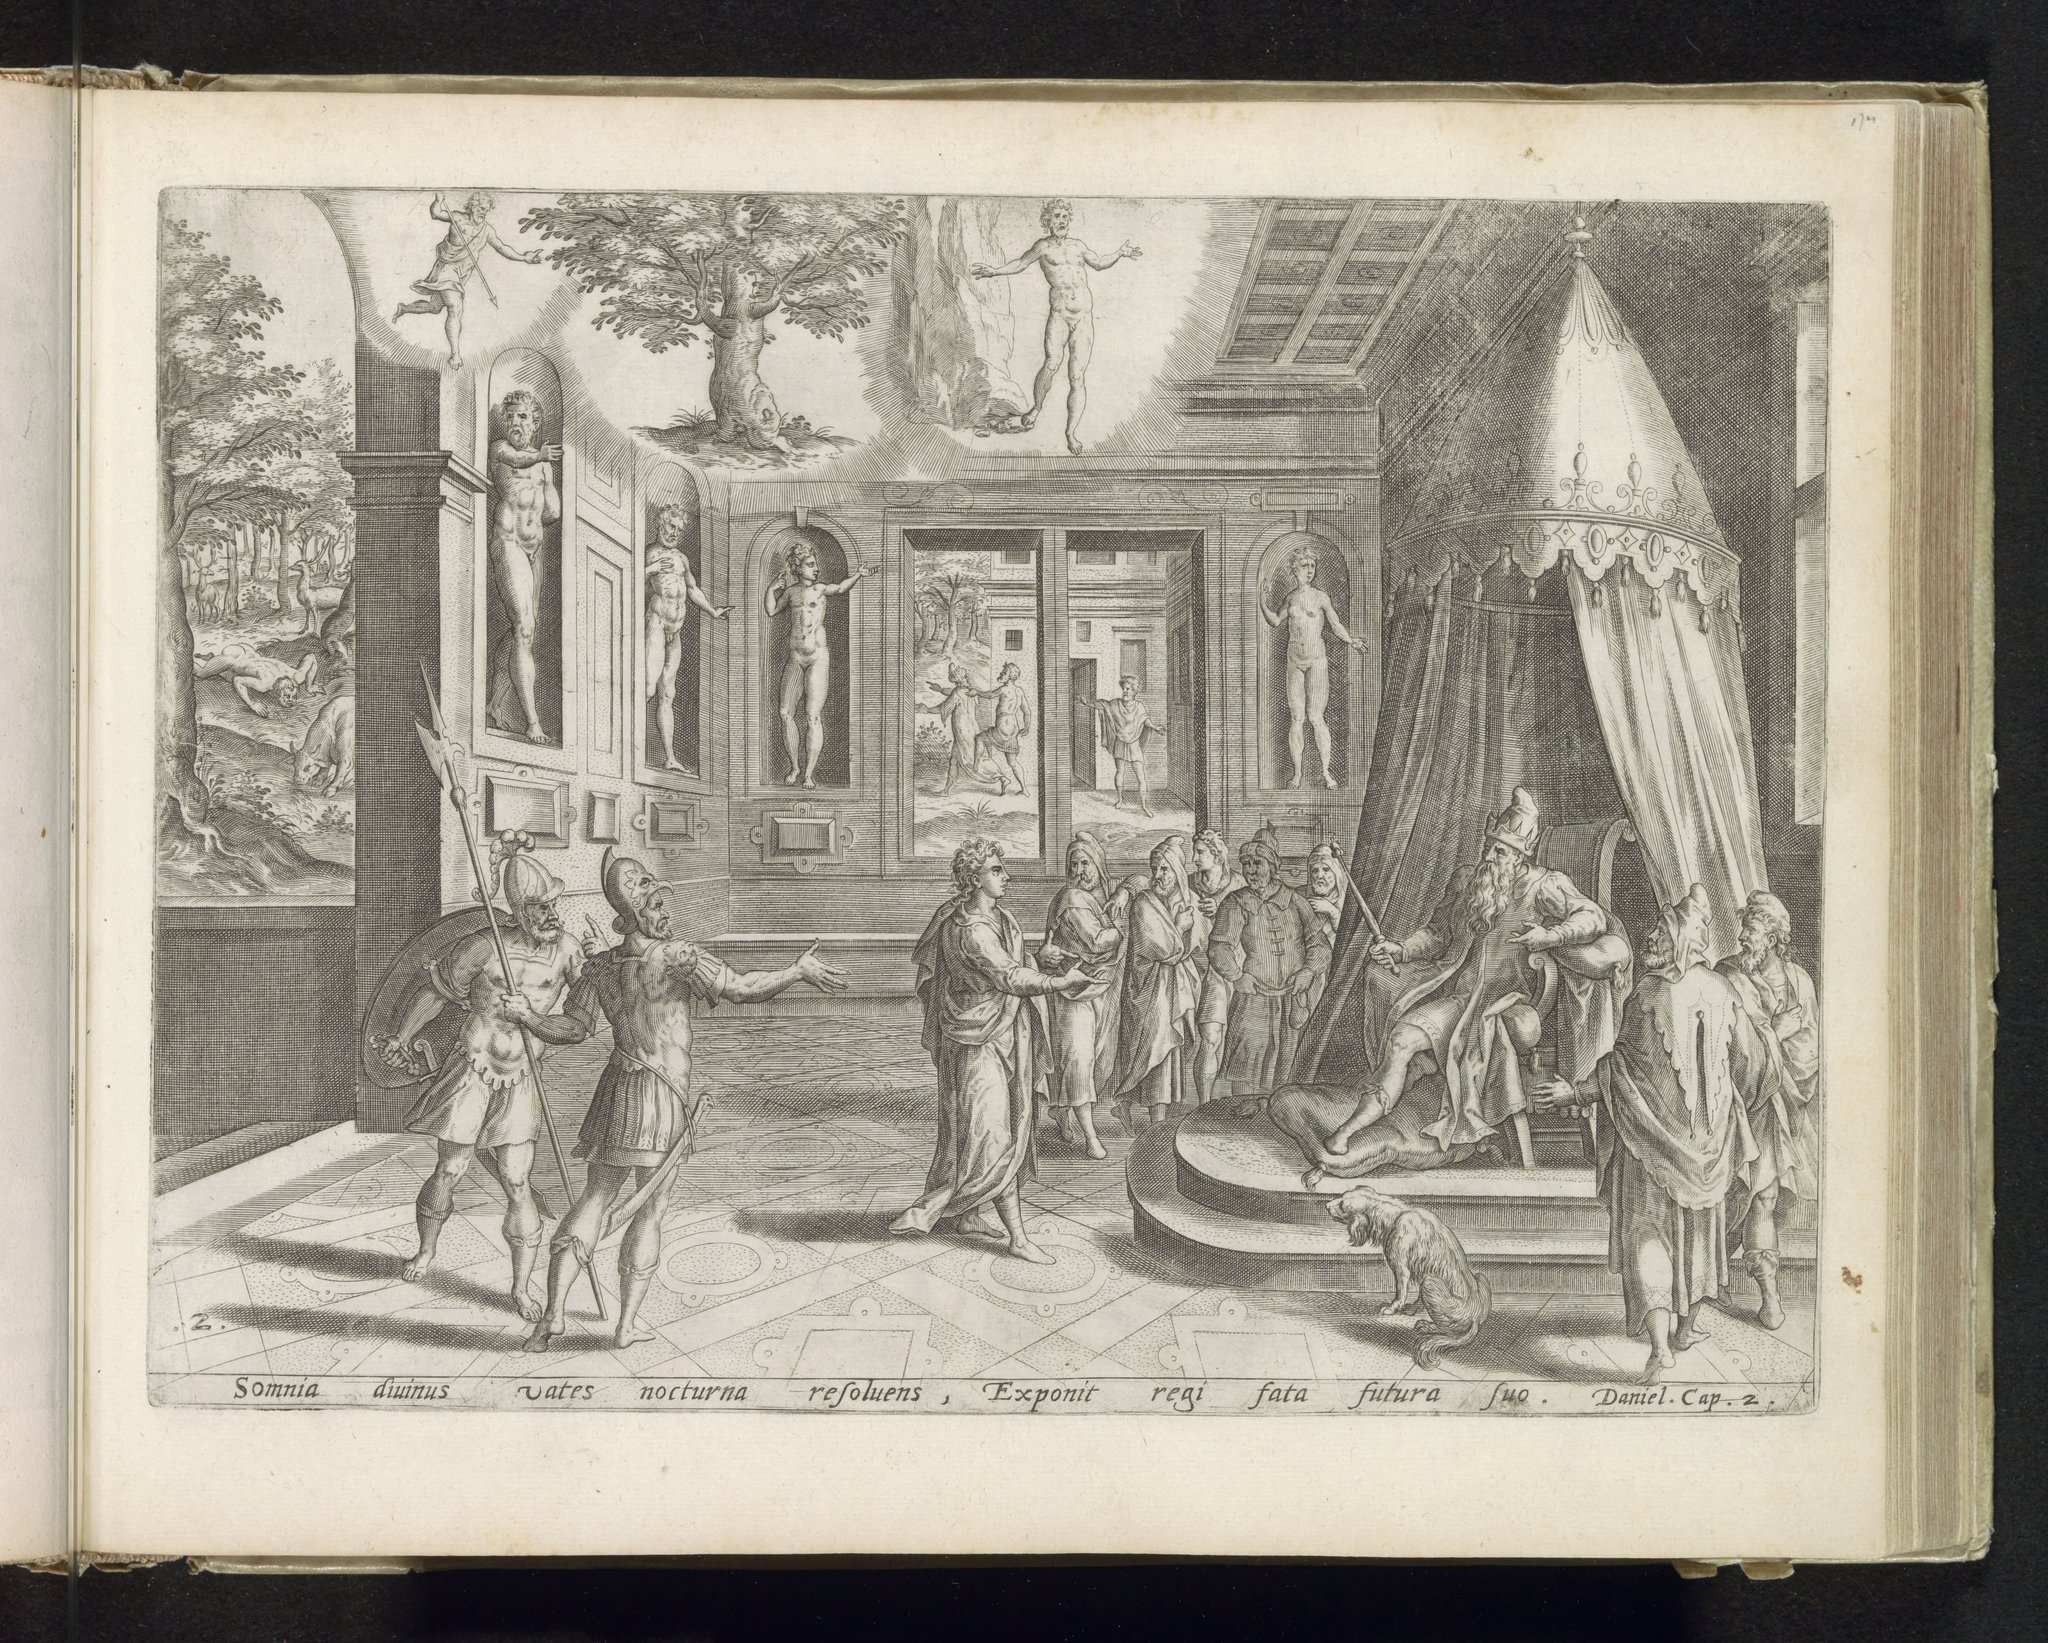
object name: print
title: Geschiedenis van Daniël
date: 1585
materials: paper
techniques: engraving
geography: antwerp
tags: king nebuchadnezzar's madness: long-haired, he creeps on all fours, eating grass, king nebuchadnezzar, when overcome by madness, is seized and expelled from the city, king nebuchadnezzar dreams of a great statue, daniel before king nebuchadnezzar, interpreting his dream, king nebuchadnezzar dreams of a tree that must be cut down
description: Daniël staat voor de troon van koning Nebukadnessar en legt de dromen van de koning uit. Bovenaan zijn de dromen van de koning te zien. Een wachter daalt links uit de hemel en geeft een opdracht de grote boom om te hakken. Rechts de droom van het beeld met het hoofd van goud en voeten van ijzer en leem. Daniël vertelt dat de eerste droom betekent dat de koning zal worden verstoten en zeven jaar als een dier zal leven. Op de achtergrond is te zien hoe Nebukadnessar wordt weggestuurd. Links in het landschap leeft Nebukadnessar als een dier en eet gras. Onder de voorstelling een verwijzing in het Latijn naar de Bijbeltekst in Dan. 2. De droom uit Dan. 4. staat in deze voorstelling echter centraal. Deze prent maakt deel uit van een album.